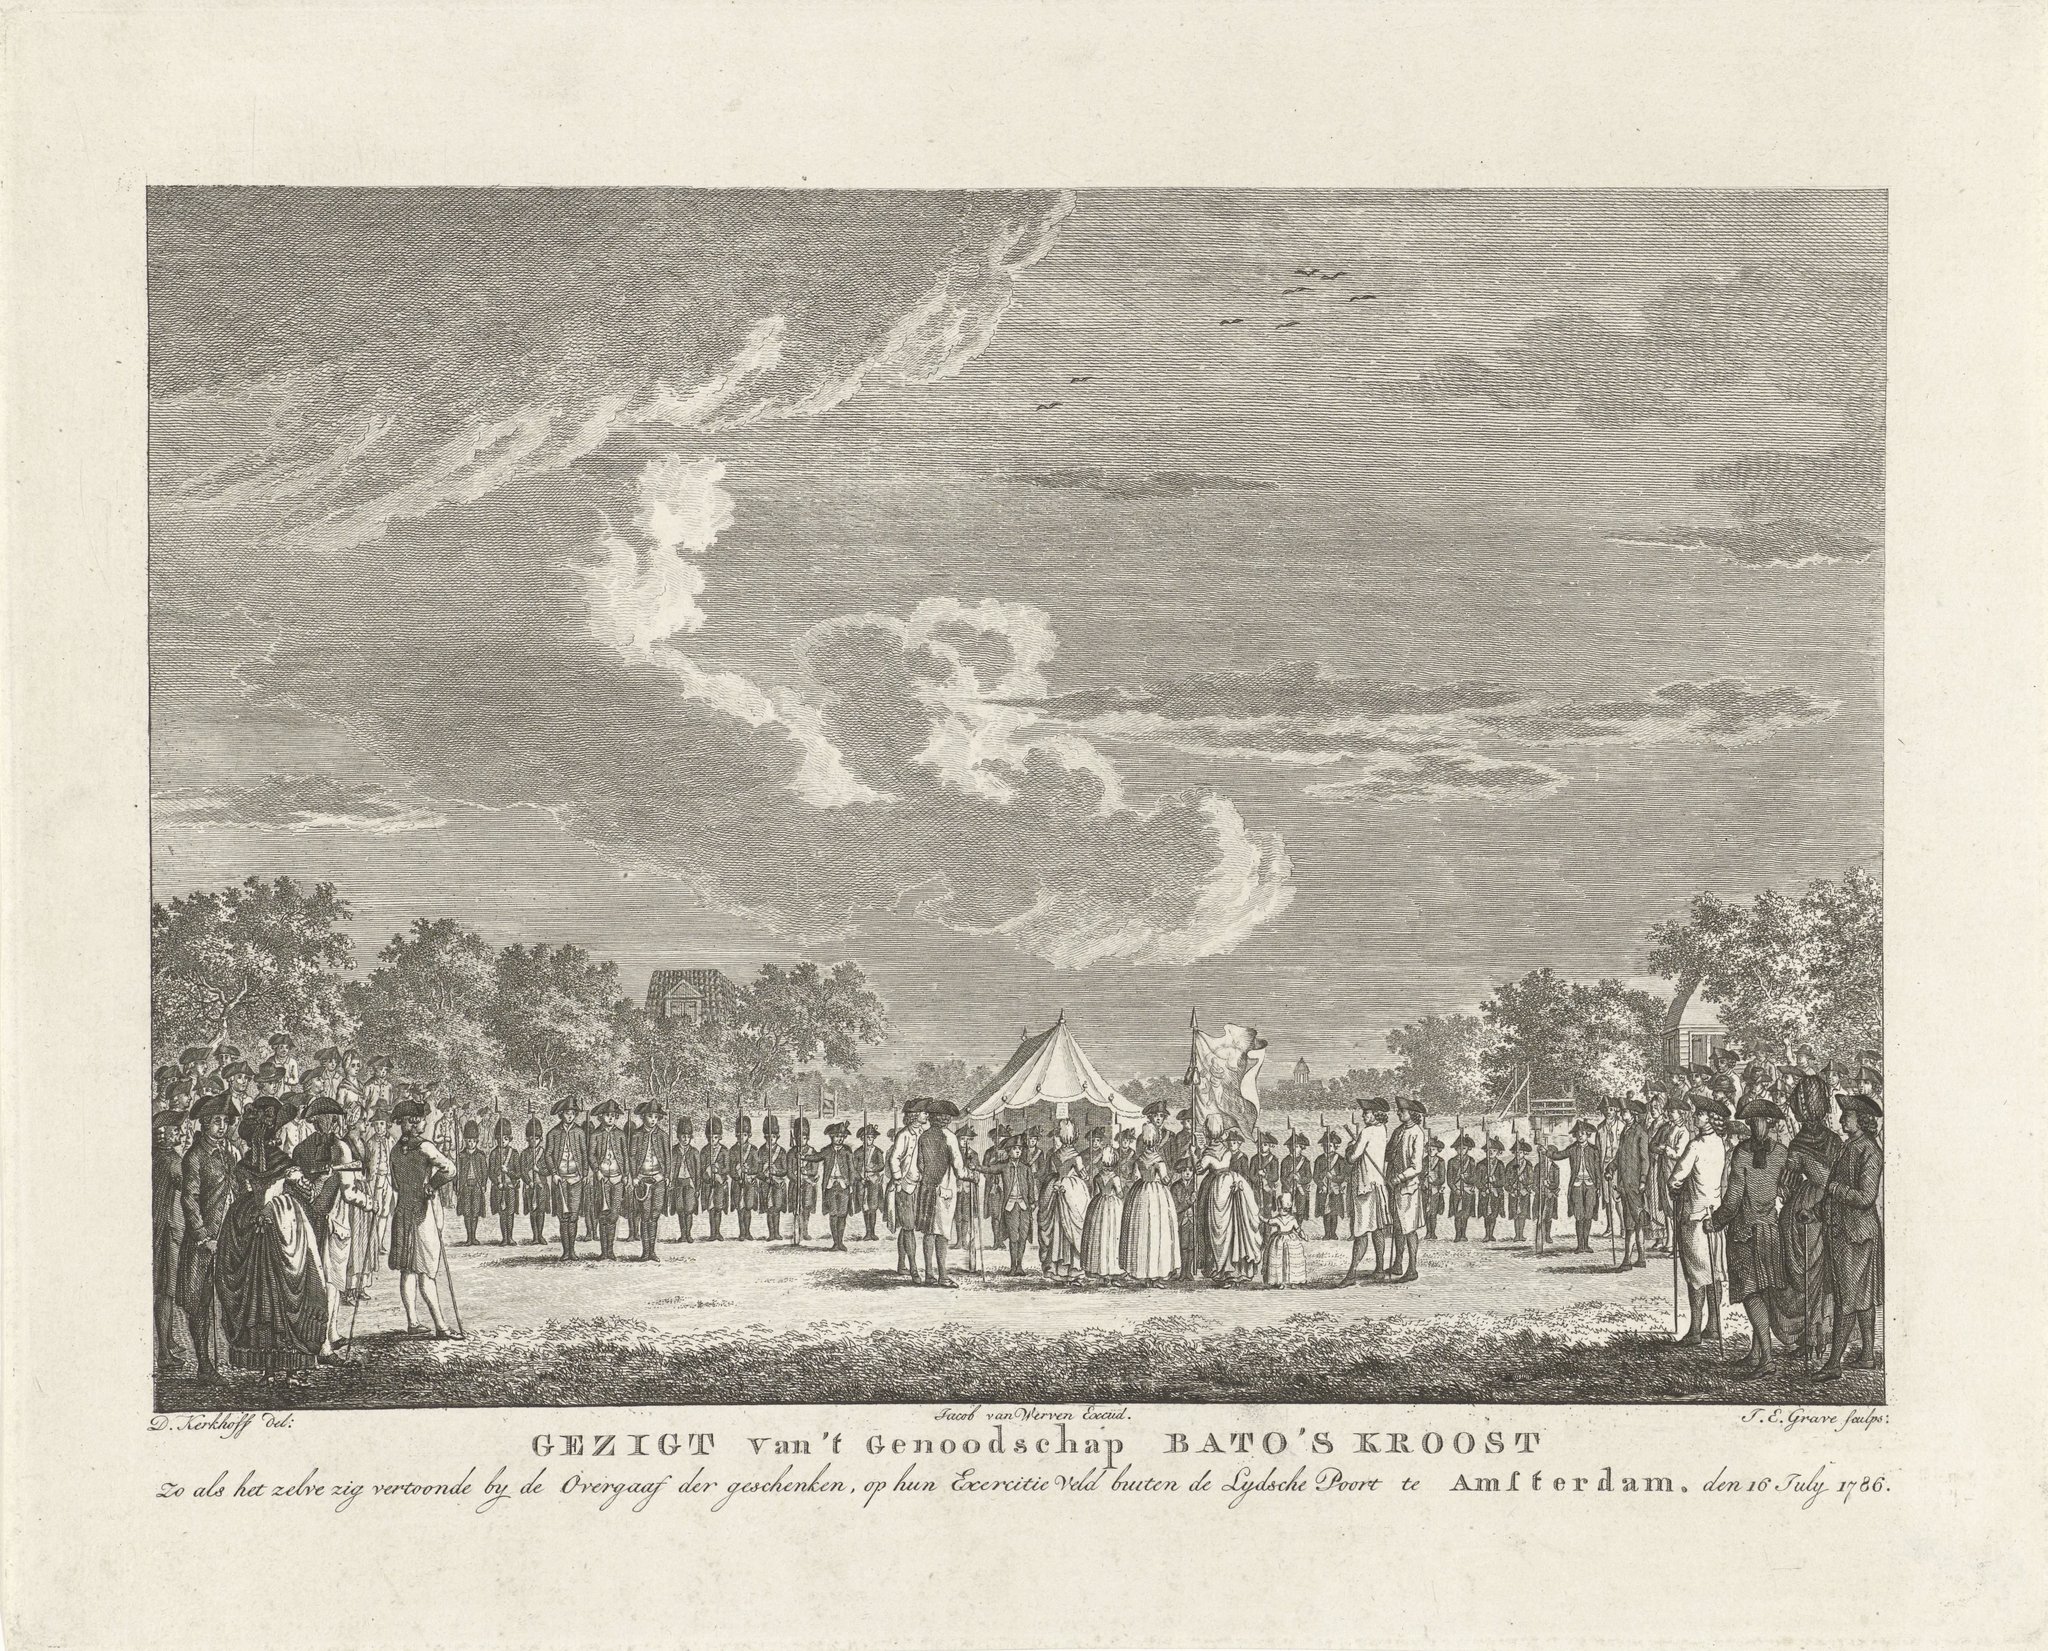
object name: print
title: Gezigt van het Genoodschap Bato's kroost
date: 1786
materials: paper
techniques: engraving, etching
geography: amsterdam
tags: patriots (1780-1795)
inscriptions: collector's mark: Lugt 2228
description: Buiten de Leidse poort van Amsterdam ontvangt het Amsterdamse exercitiegenootschap "Bato's kroost" in 1786 het vaandel, de trom en de geweren die zijn status als vrijcorps bevestigen. In het midden worden de geschenken overhandigd. De prent heeft een Nederlands onderschrift.